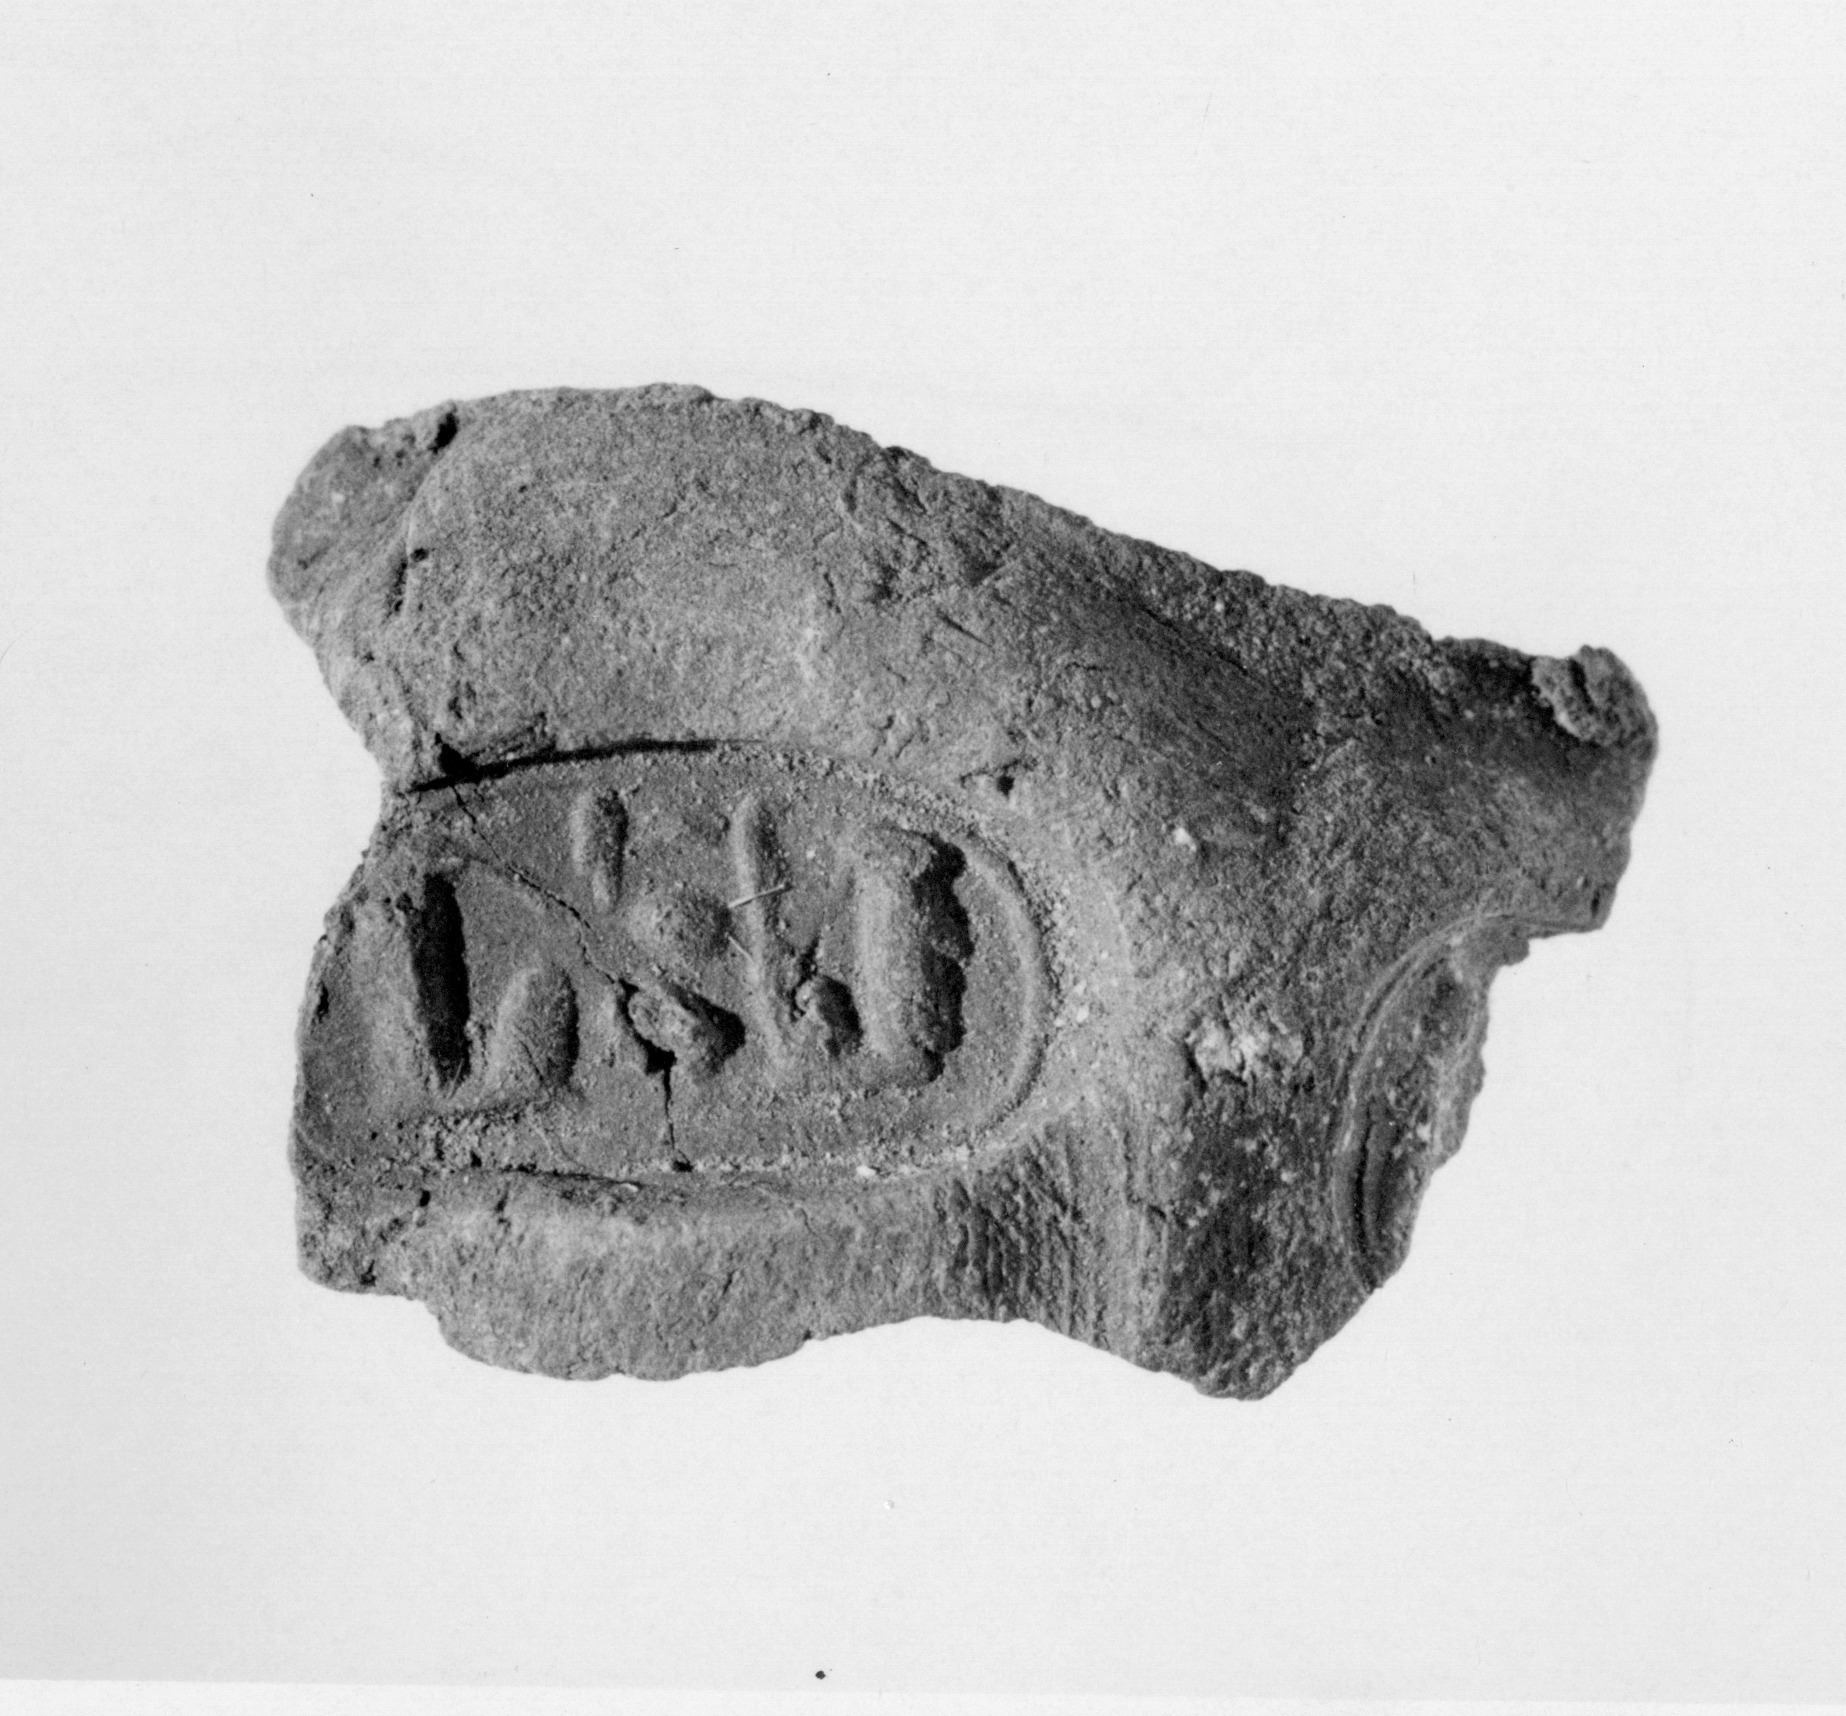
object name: sealing, nebmaatre, amenhotep iii, horus, re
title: Document Sealing With the Throne Name of Amenhotep III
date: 1390-1352 BCE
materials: mud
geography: egypt